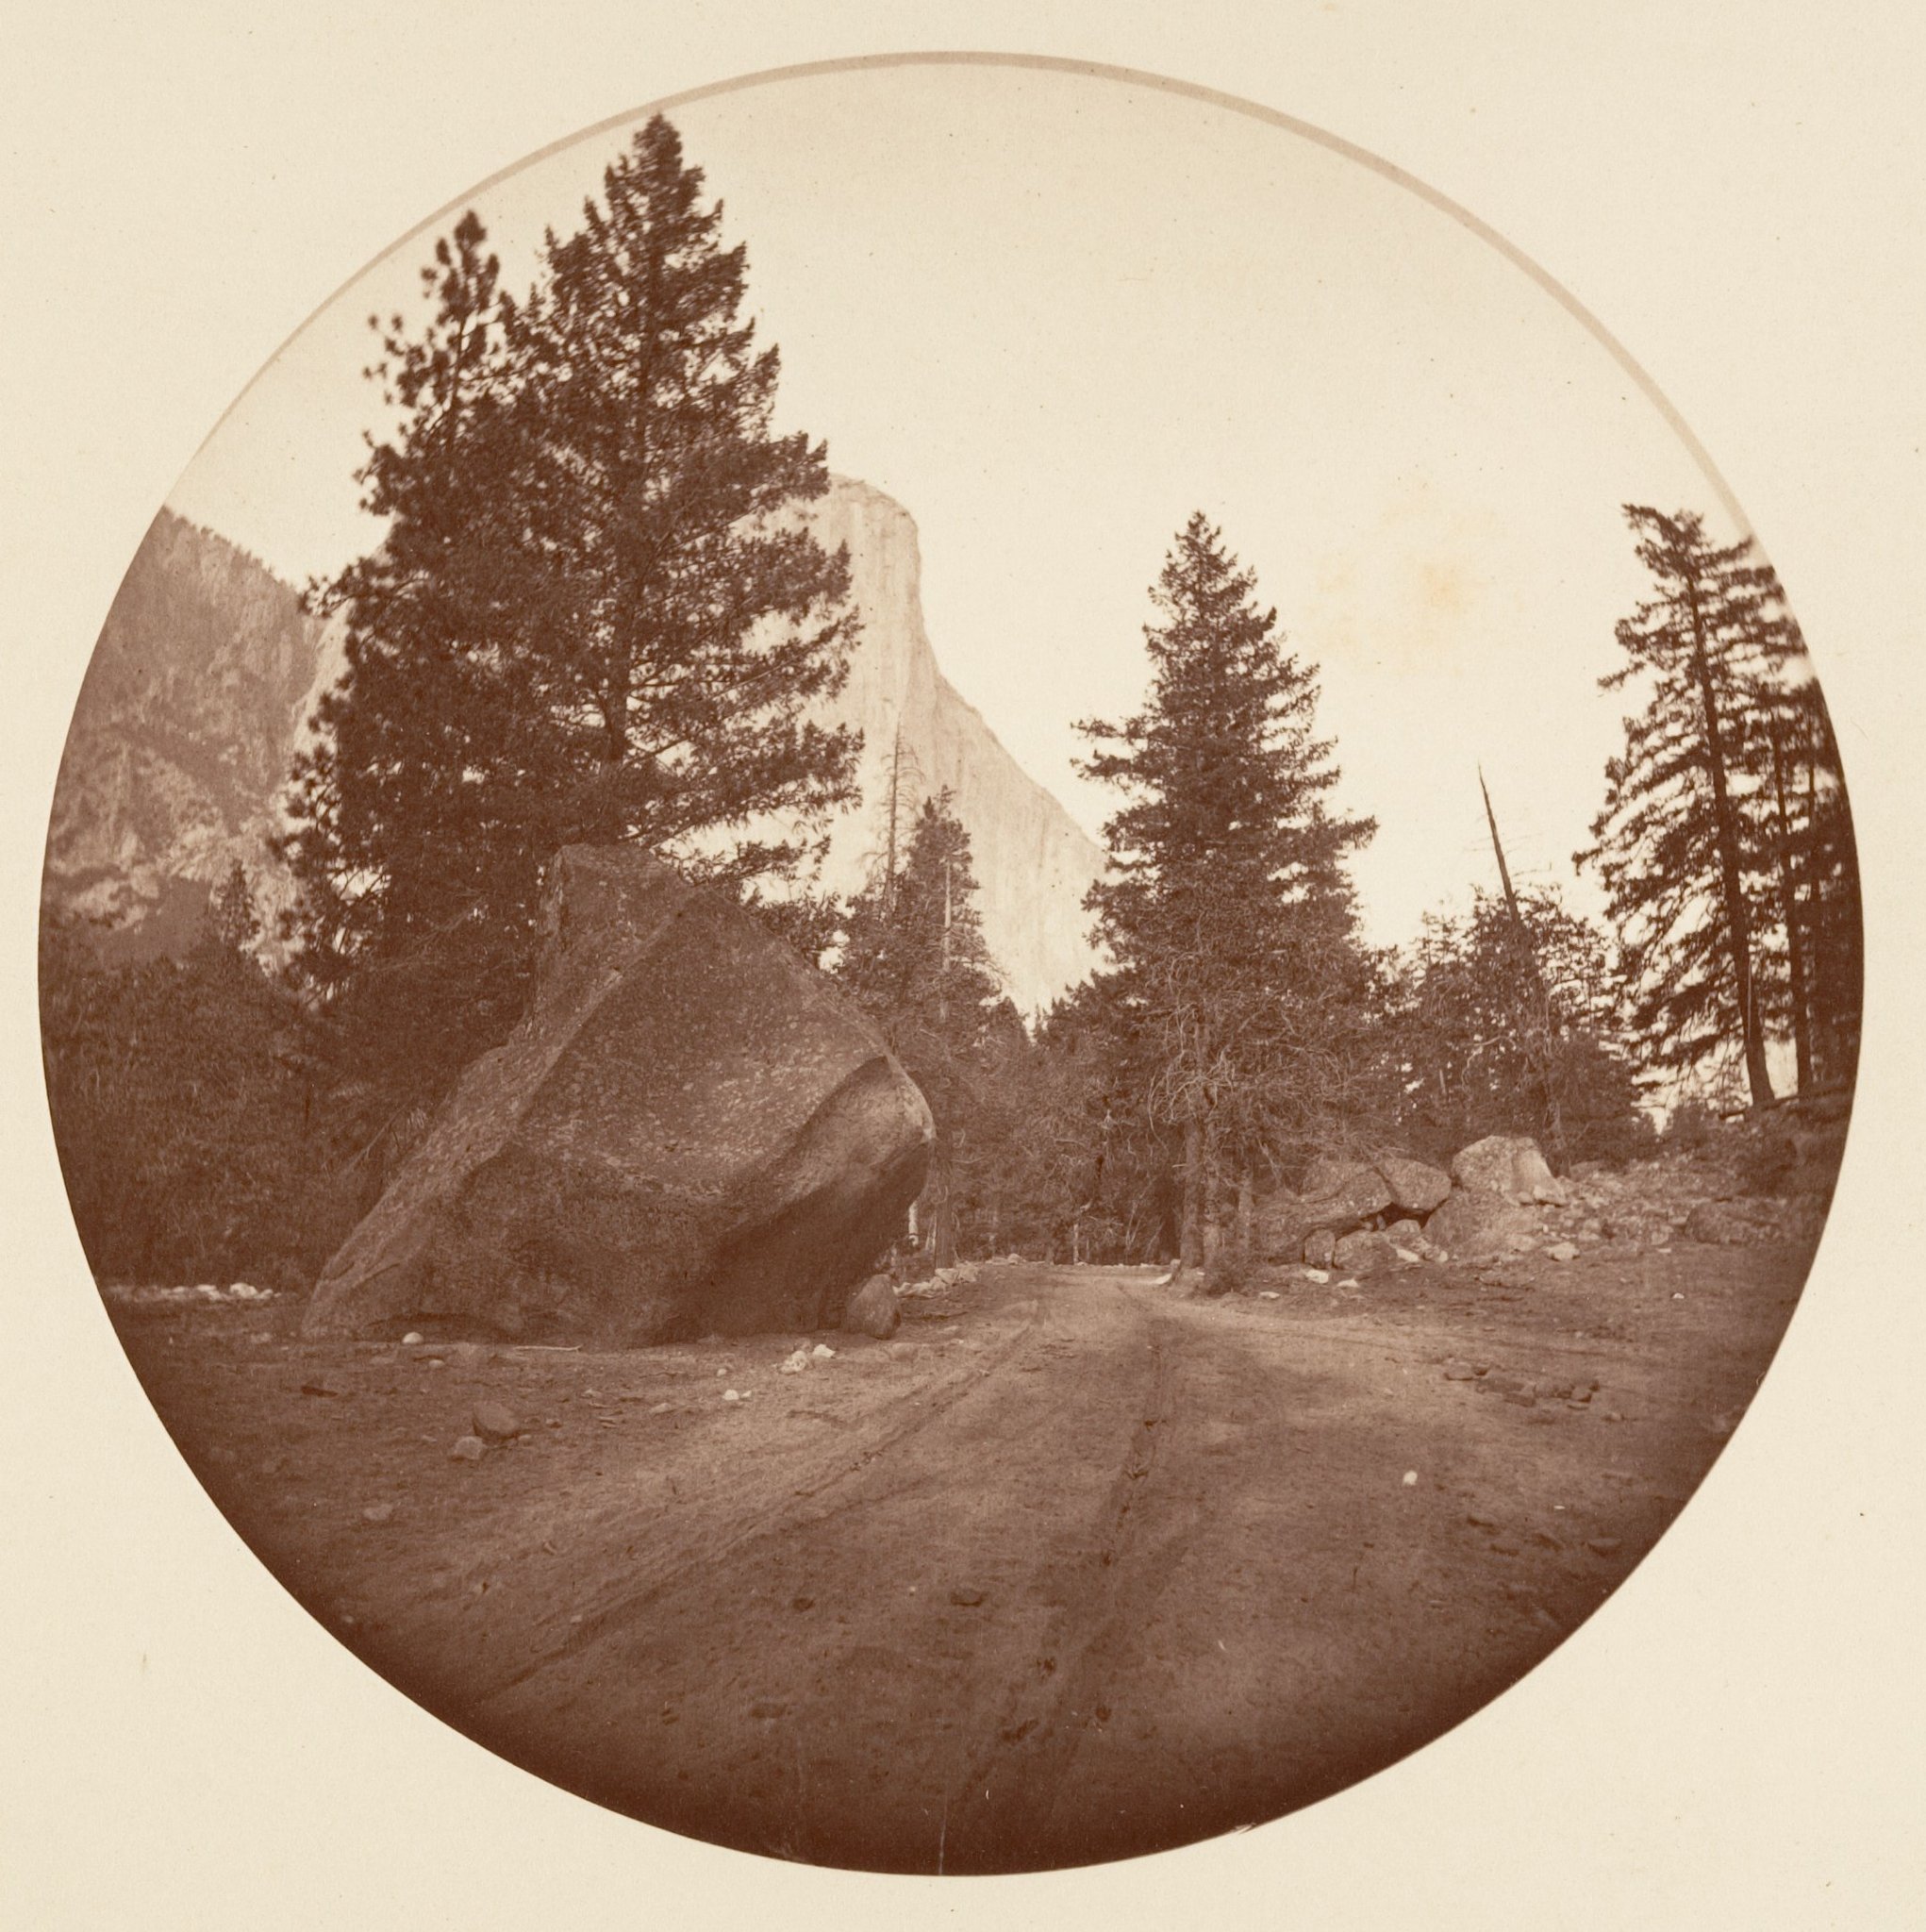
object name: photograph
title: [Yosemite National Park, California]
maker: carleton e. watkins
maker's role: artist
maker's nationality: american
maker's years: 1829-1916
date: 1878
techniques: albumen silver print, glass negative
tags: mountains,landscapes